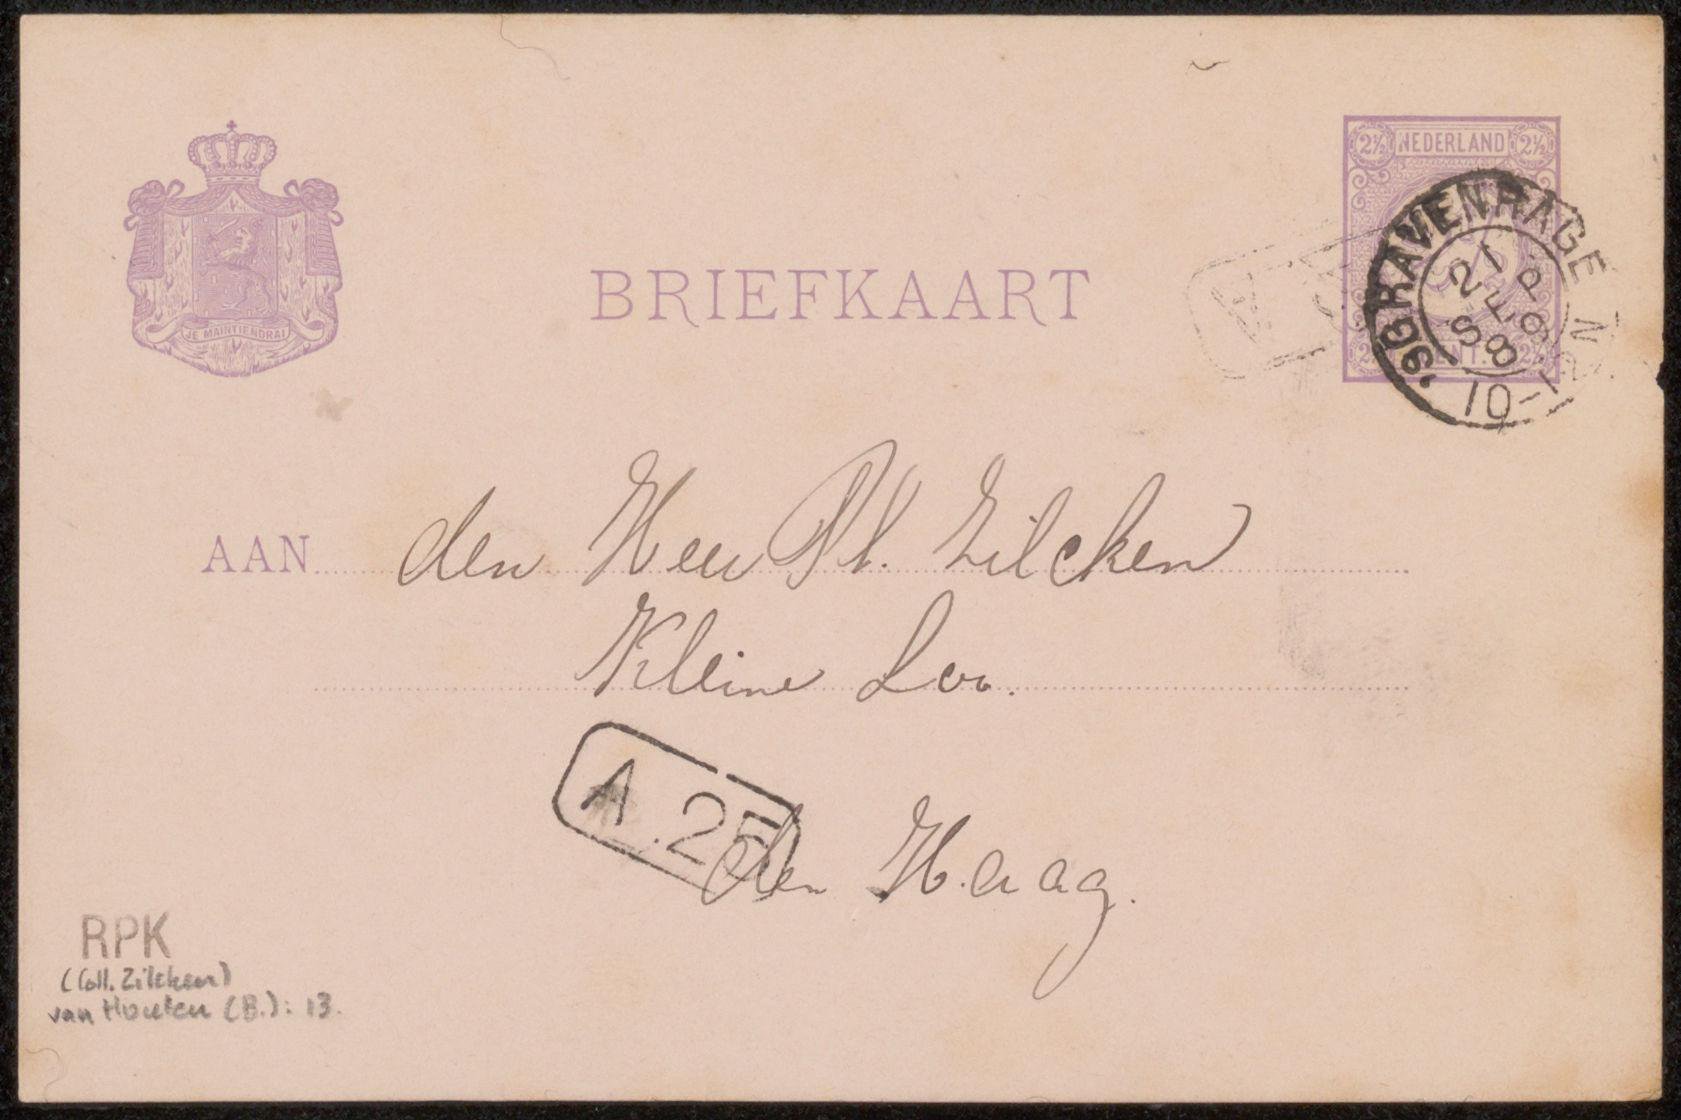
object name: postcard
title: Briefkaart aan Philip Zilcken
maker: barbara elisabeth van houten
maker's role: draughtsman, print maker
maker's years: 1862-1950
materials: cardboard, ink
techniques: pen, writing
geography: the hague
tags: james abbott mcneill whistler, the hague, painter, draughtsman, philip zilcken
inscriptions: collector's mark: ‘RPK’